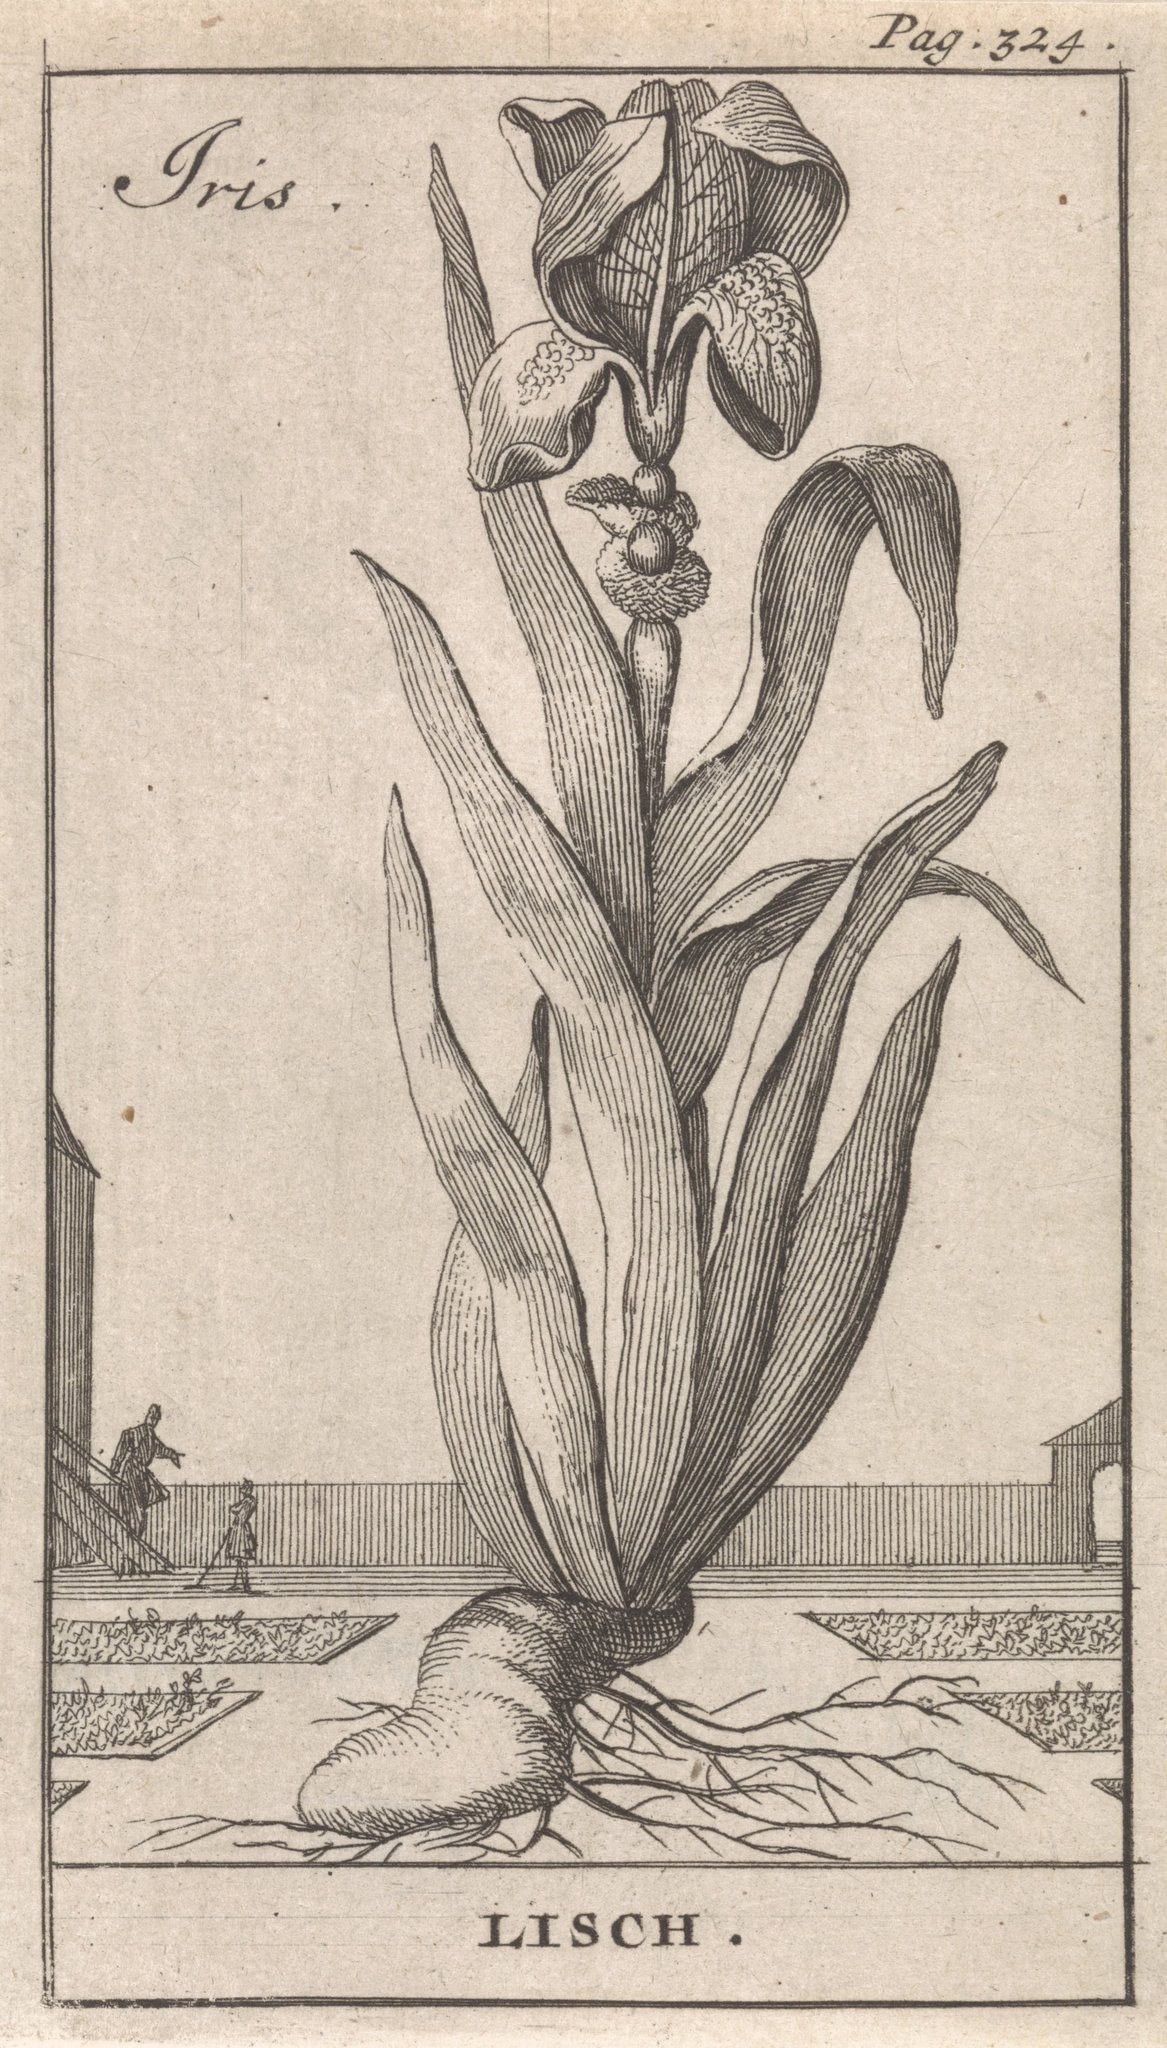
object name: print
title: Title Page and Eight Prints with Flowers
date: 1698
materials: paper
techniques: etching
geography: amsterdam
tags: plants and herbs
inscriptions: collector's mark: Lugt 2228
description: These floral prints by Jan Luyken are from the Nederlandschen Herbarius published by the physician Steven Blankaart in 1698. This Dutch herbal describes indigenous plants and trees with their medicinal properties. Incidentally, not all flowers had a practical medical application. But they were quite suitable ‘to make nosegays and posies’ or ‘simply a pleasure to look at’.